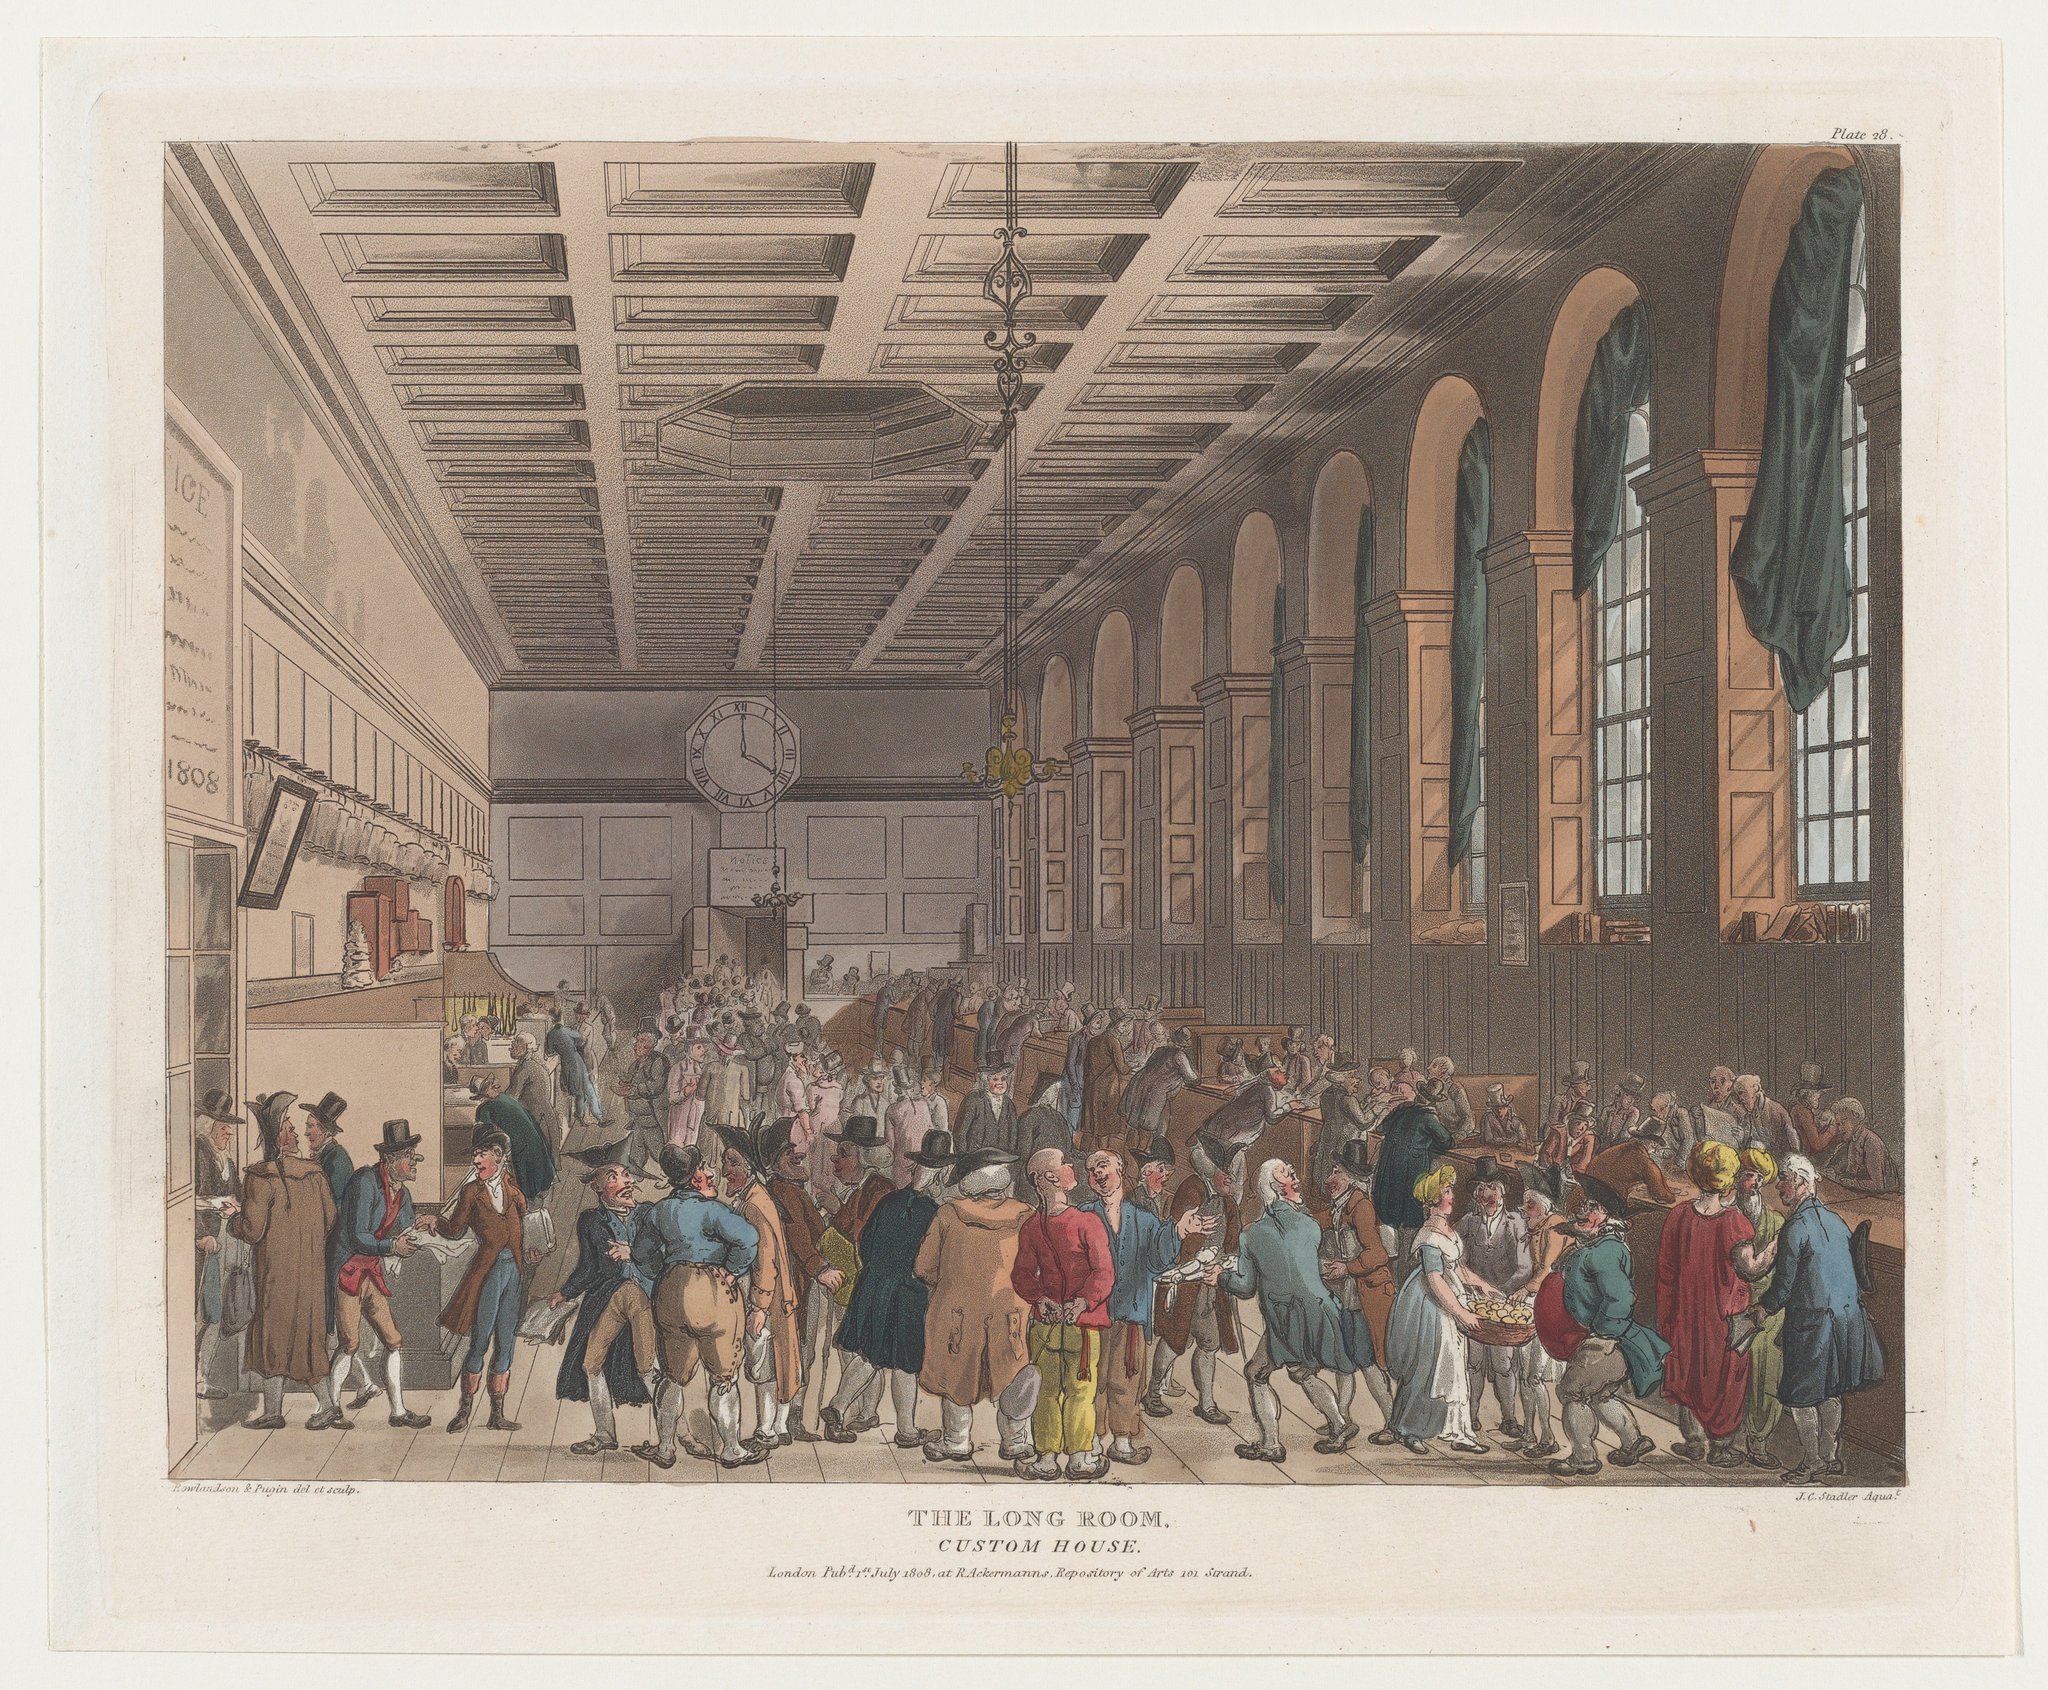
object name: print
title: The Long Room, Custom House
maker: thomas rowlandson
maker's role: artist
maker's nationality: british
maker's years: 1757-1827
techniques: aquatint, etching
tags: interiors,men,women,crowd